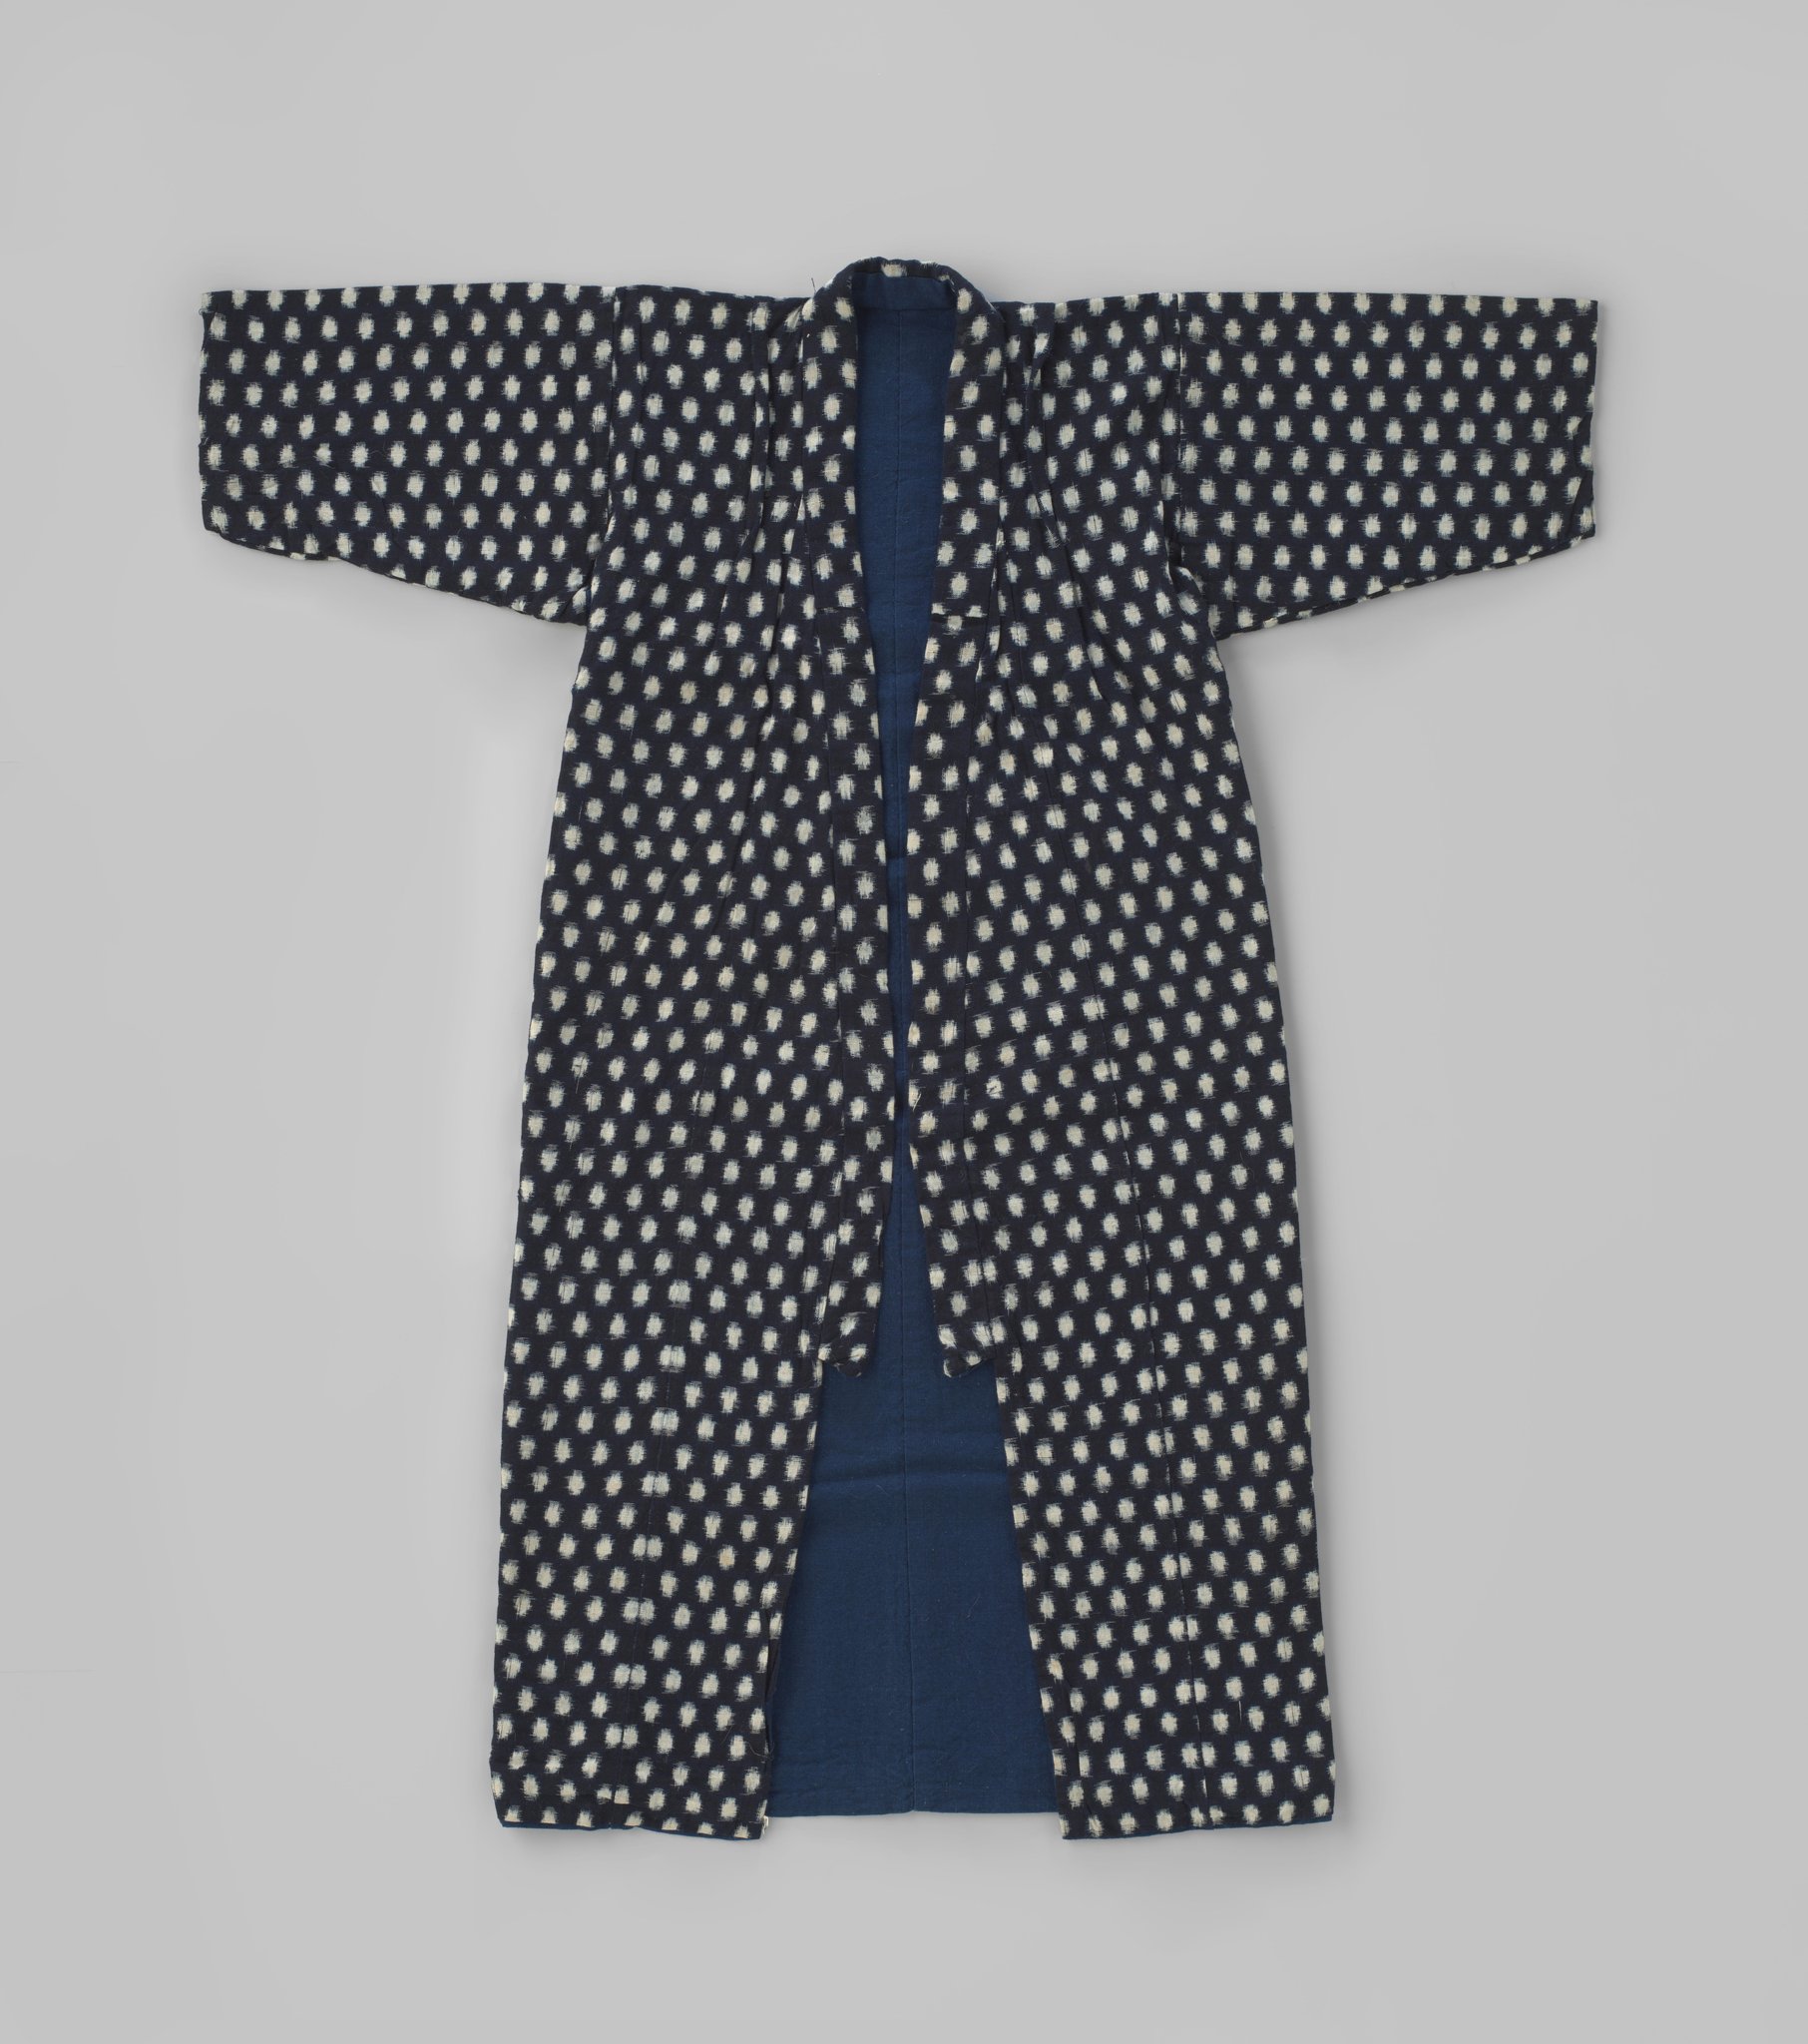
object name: kimono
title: Jongens kimono met stippen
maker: Anonymous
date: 1900-1910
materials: cotton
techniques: painting, weave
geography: japan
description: Kimono voor een jongen met een versiering over het hele vlak van witte stippen. Indigo katoen met ikat decoratie. Voering van indigo katoen.